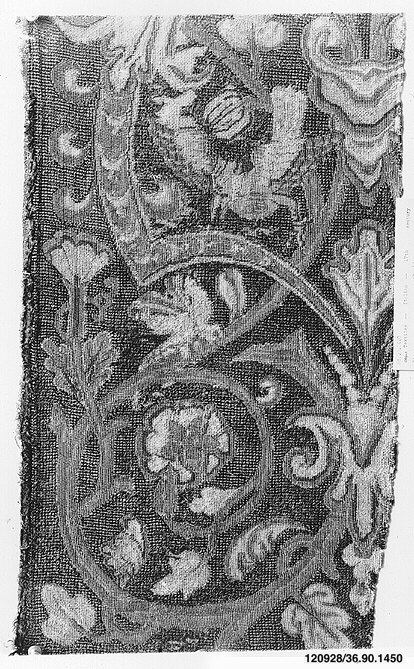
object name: piece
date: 1601-1700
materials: silk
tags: flowers,leaves